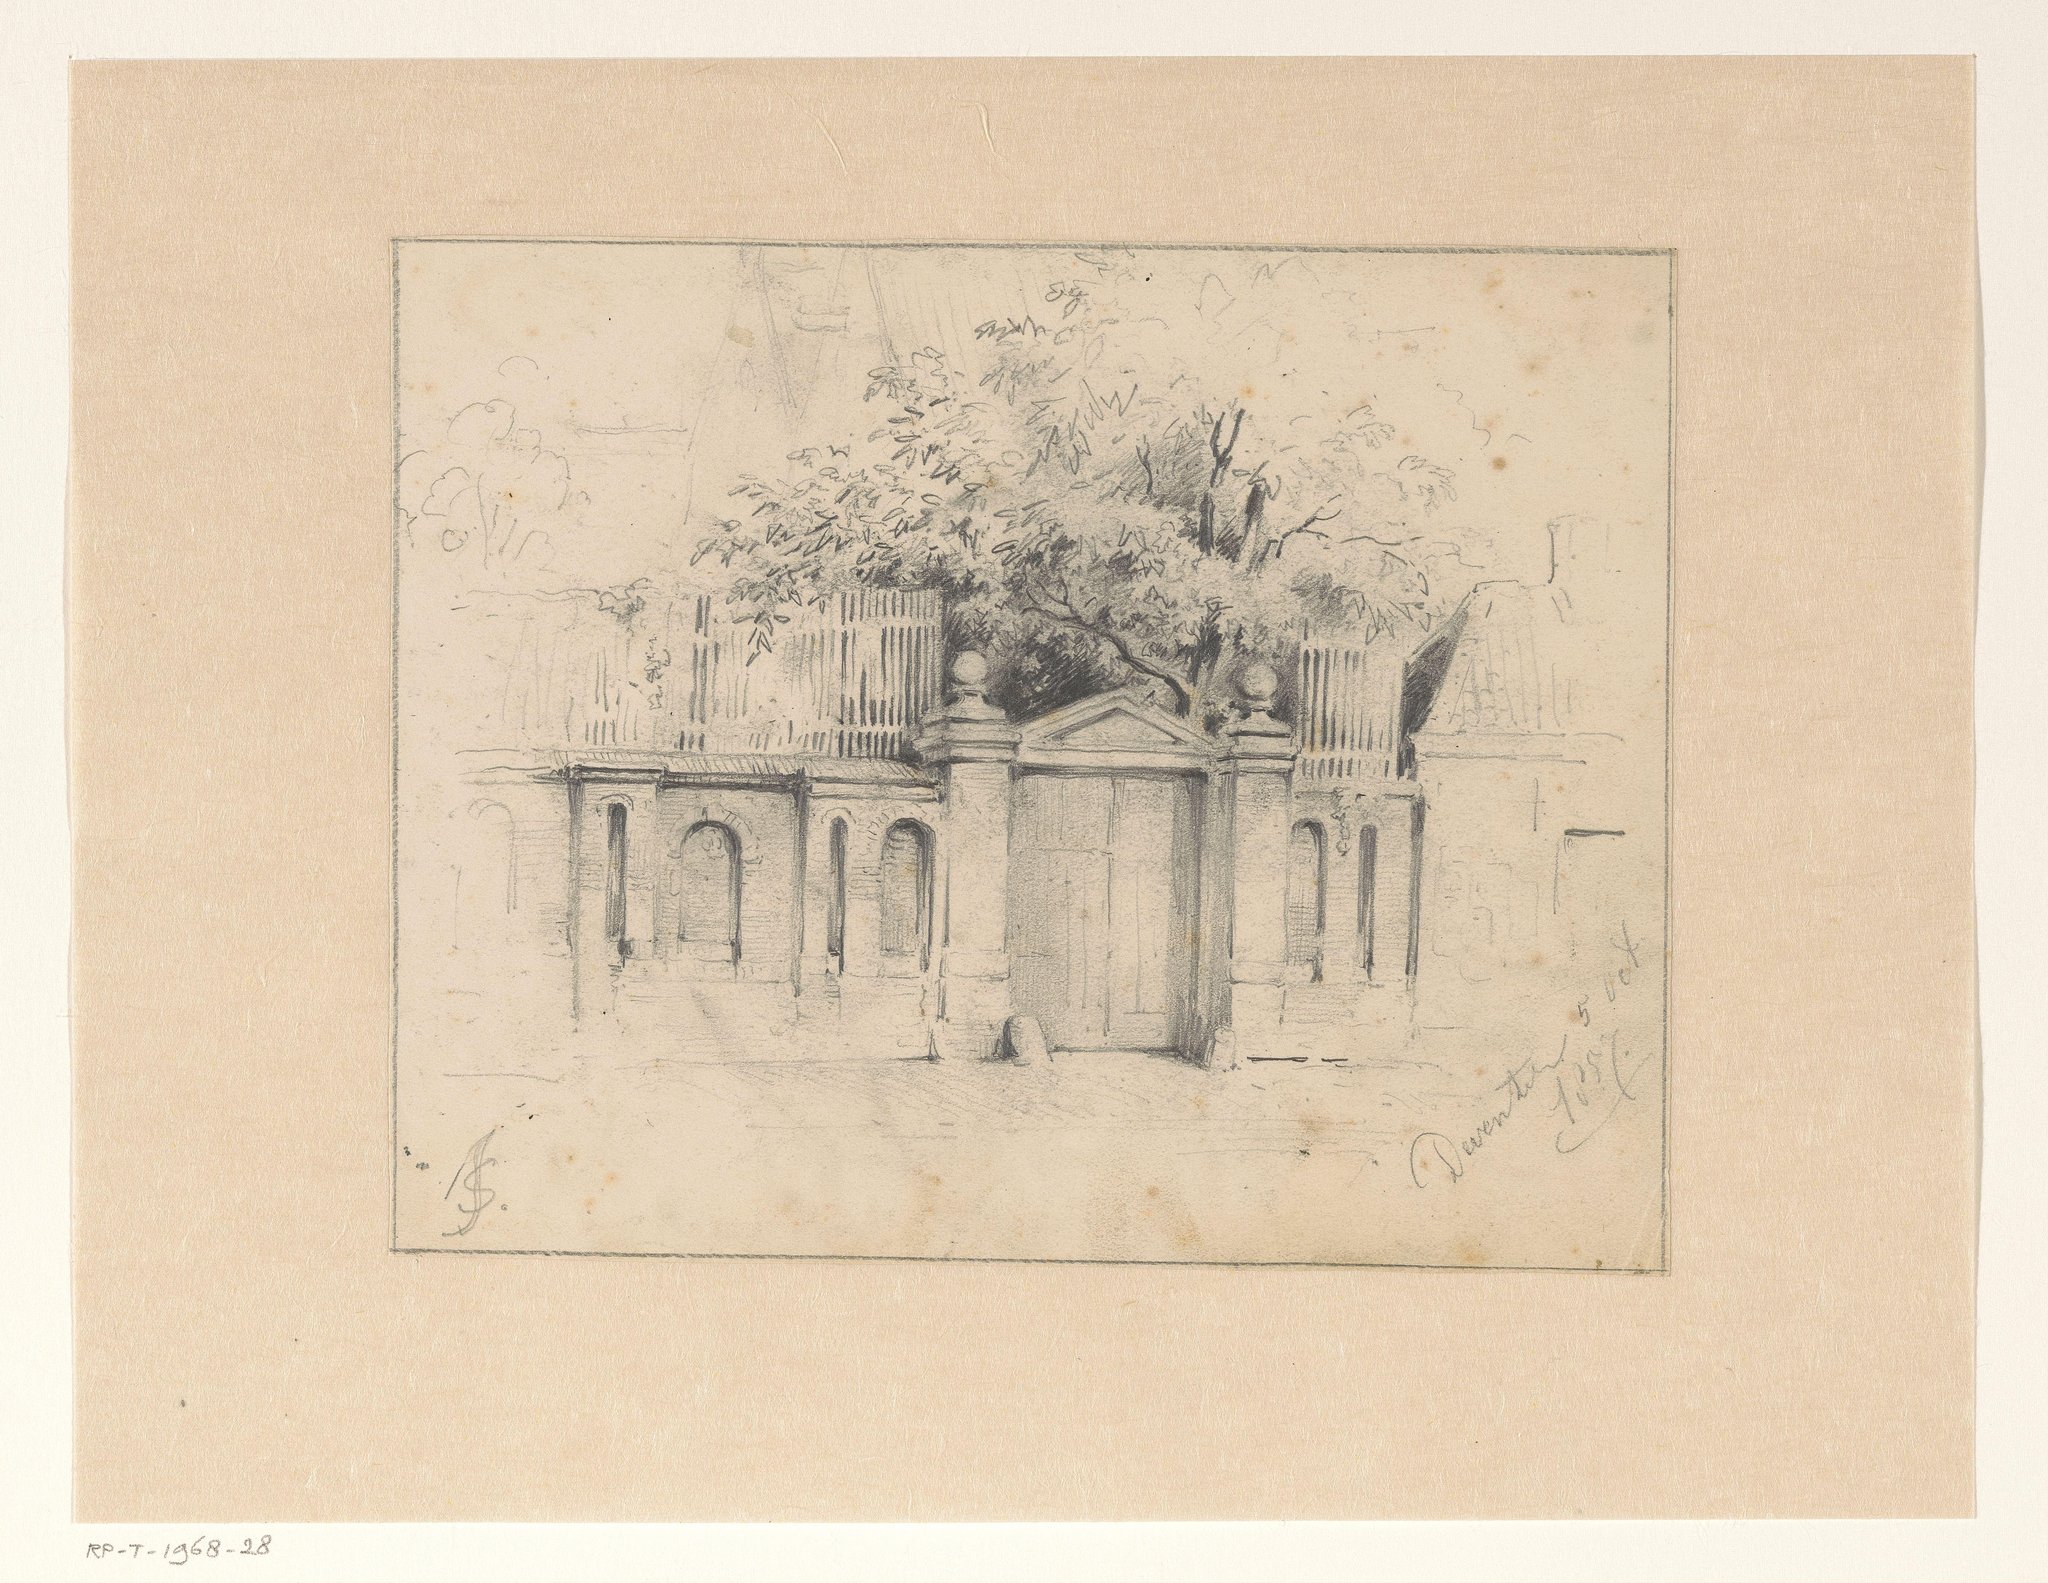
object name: drawing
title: Tuinpoort te Deventer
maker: jan striening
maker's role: draughtsman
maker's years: 1827-1903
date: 1857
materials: paper, pencil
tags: fence, wall, paling, deventer